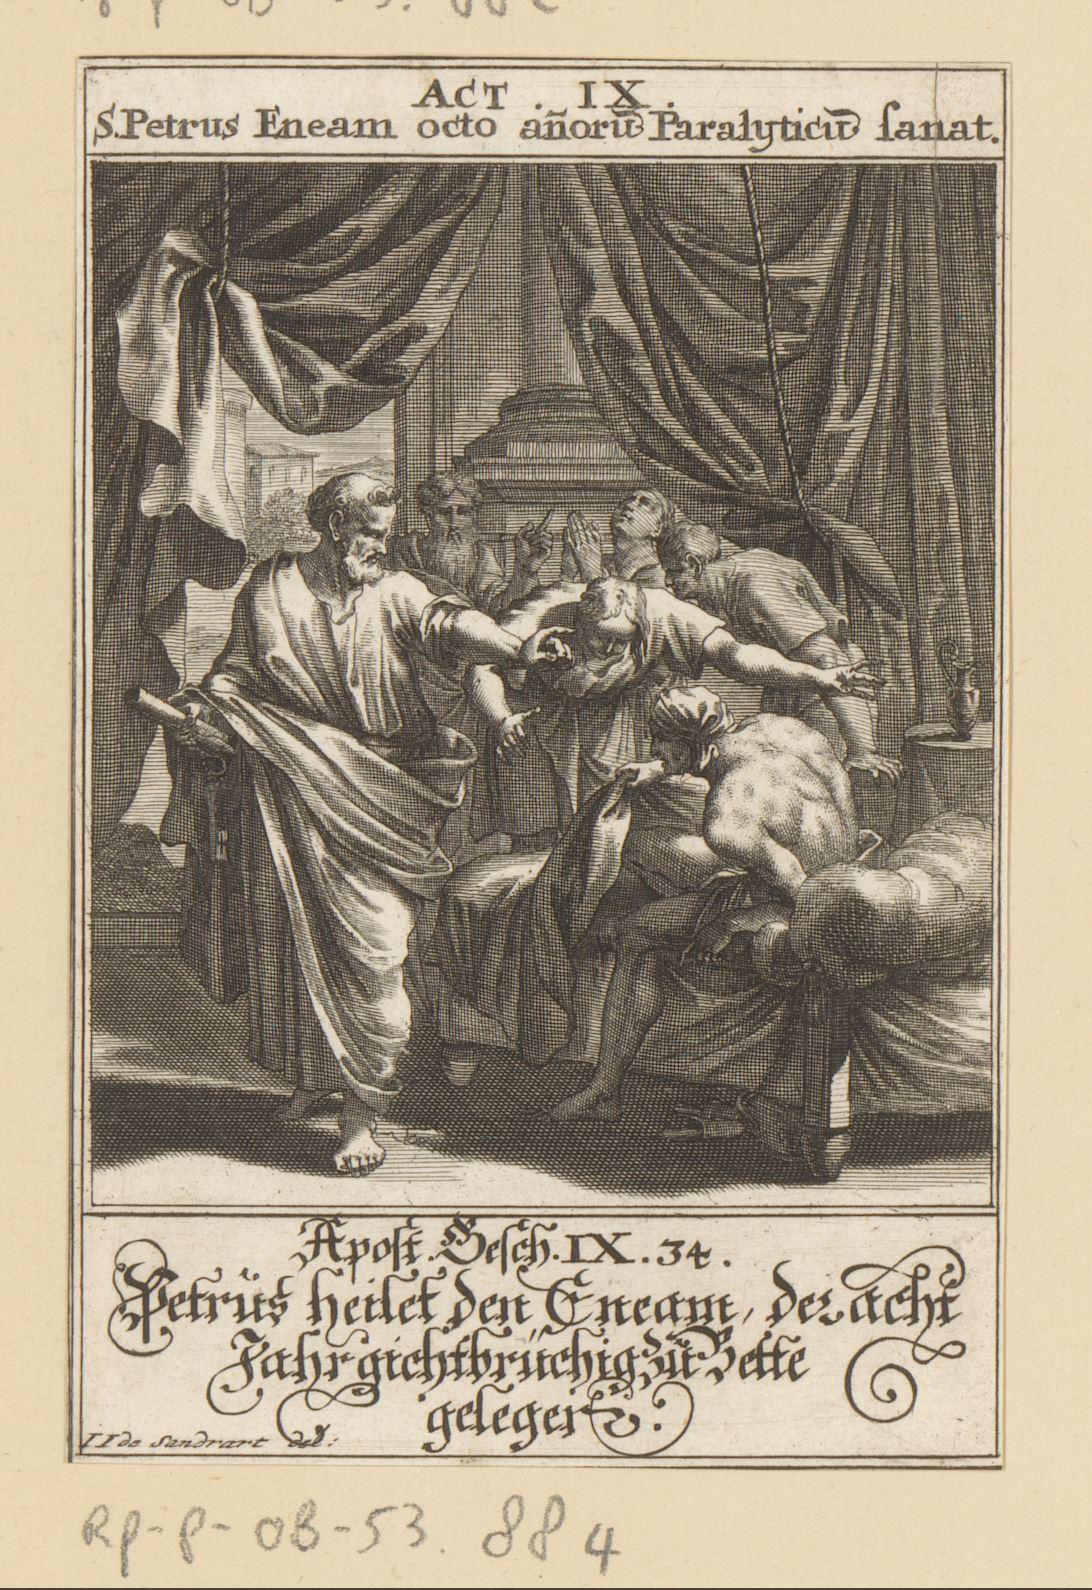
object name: print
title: Apostel Petrus geneest Aeneas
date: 1697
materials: paper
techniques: etching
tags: peter in lydda heals aeneas, who had been confined to his bed for eight years (acts 9:32-35)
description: Prent ook gebruikt in: Biblia ectypa : Bildnussen auss Heiliger Schrifft. Regensburg: Chr. Wiegel, 1697.